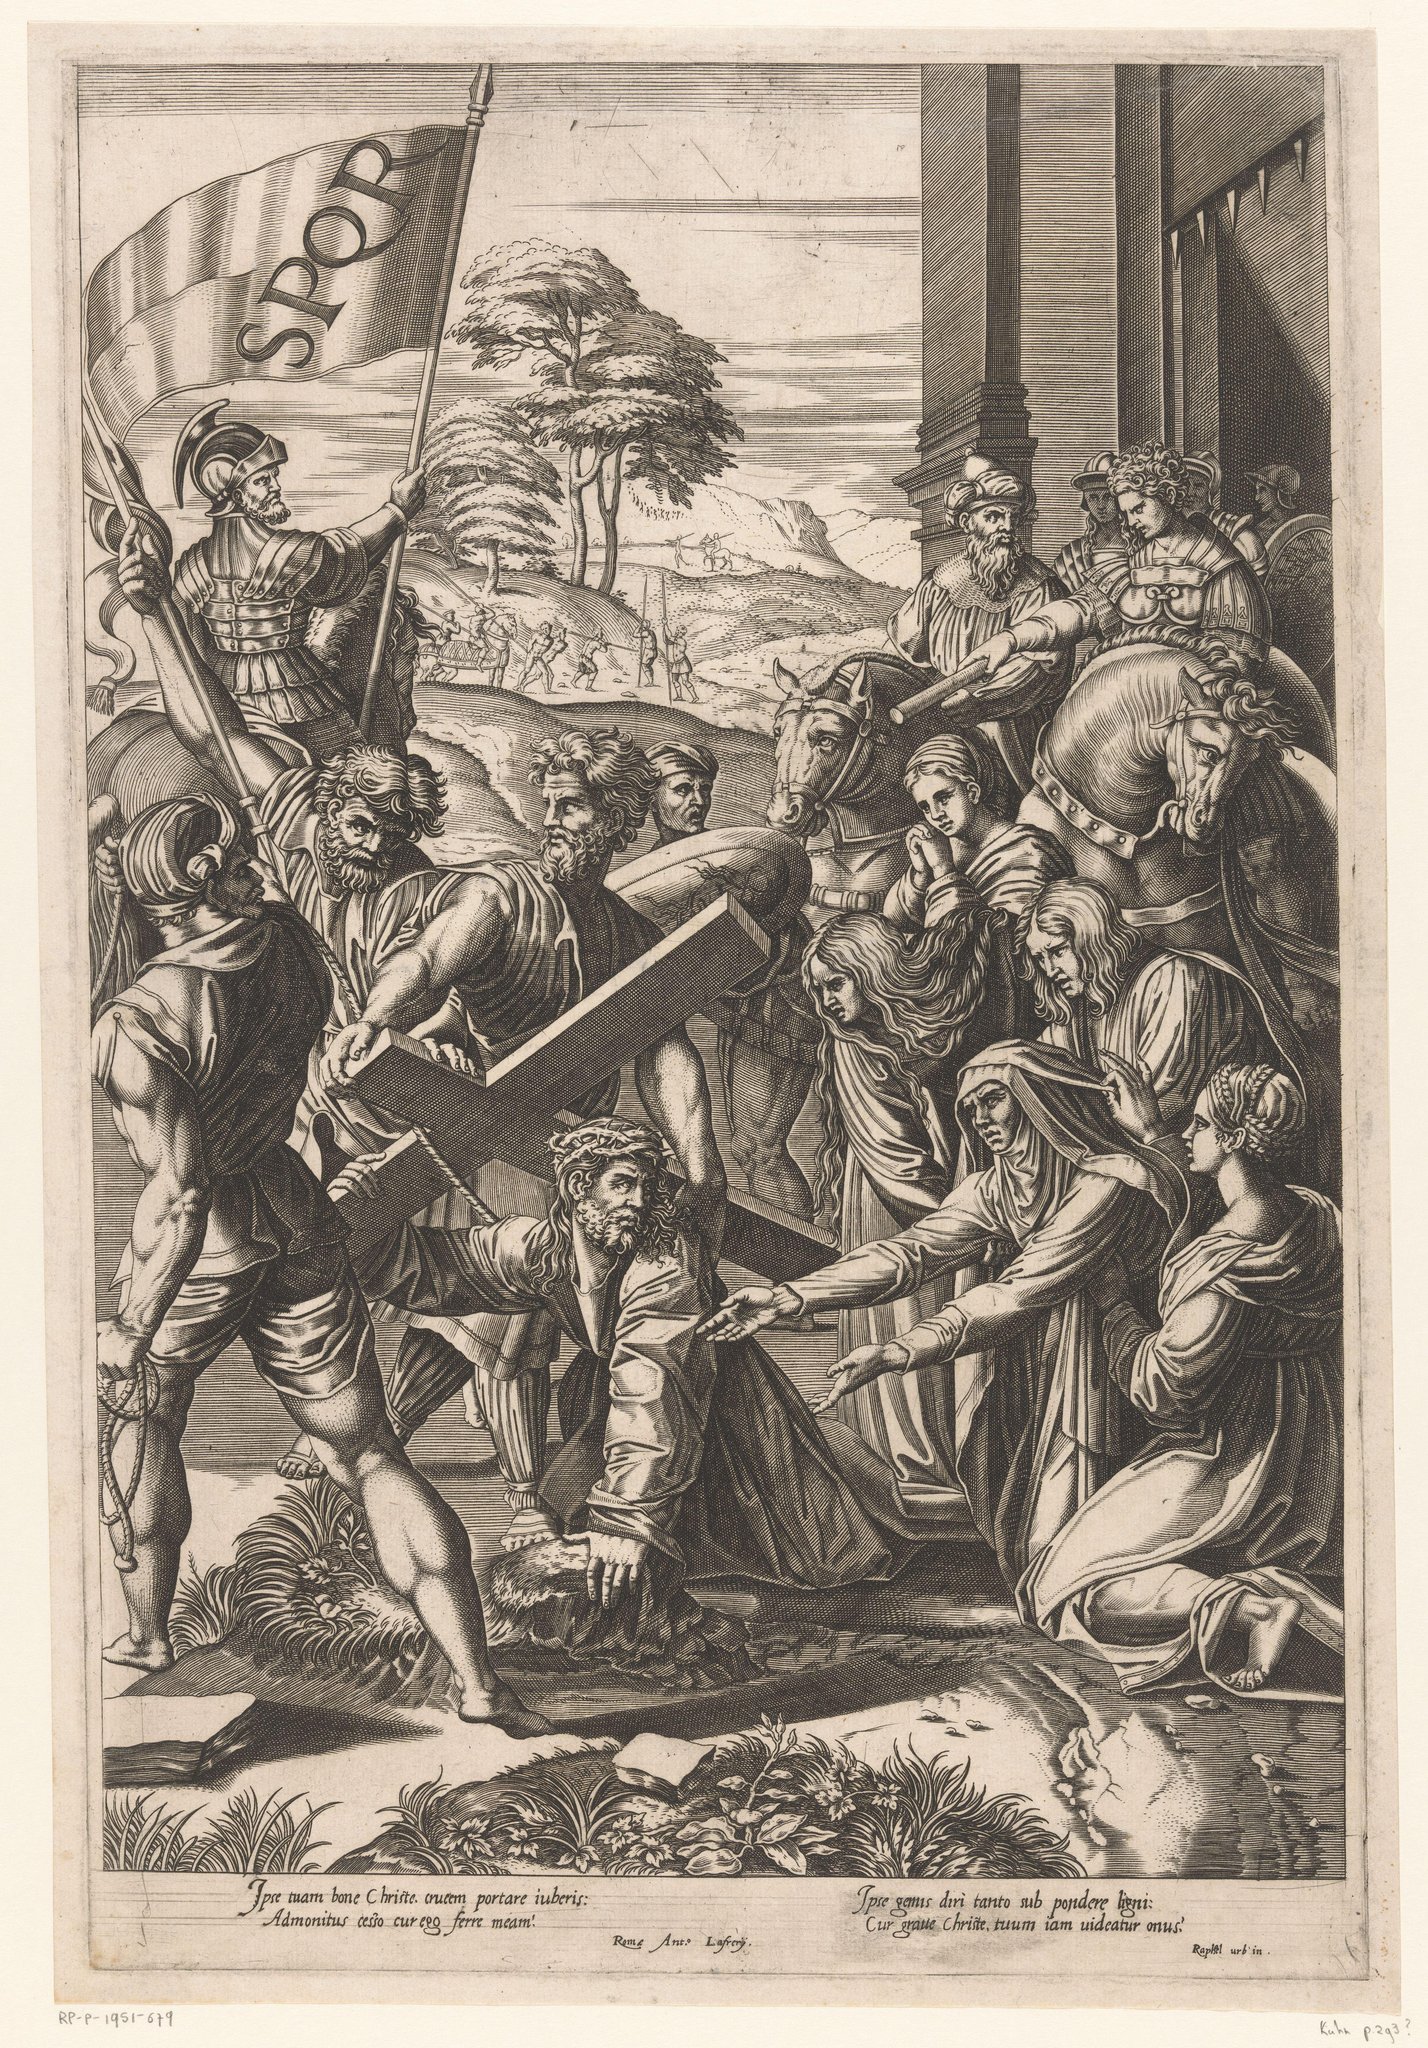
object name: print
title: Il Spasimo di Sicilia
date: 1576-1624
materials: paper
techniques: engraving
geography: italy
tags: christ collapsing ~ carrying of the cross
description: Christus bezwijkt onder het gewicht van het kruis dat hij op zijn schouders draagt op de weg naar Golgota. Op de achtergrond links een soldaat te paard met een banier met de afkorting 'SPQR'. Latijnse tekst in twee kolommen in ondermarge.